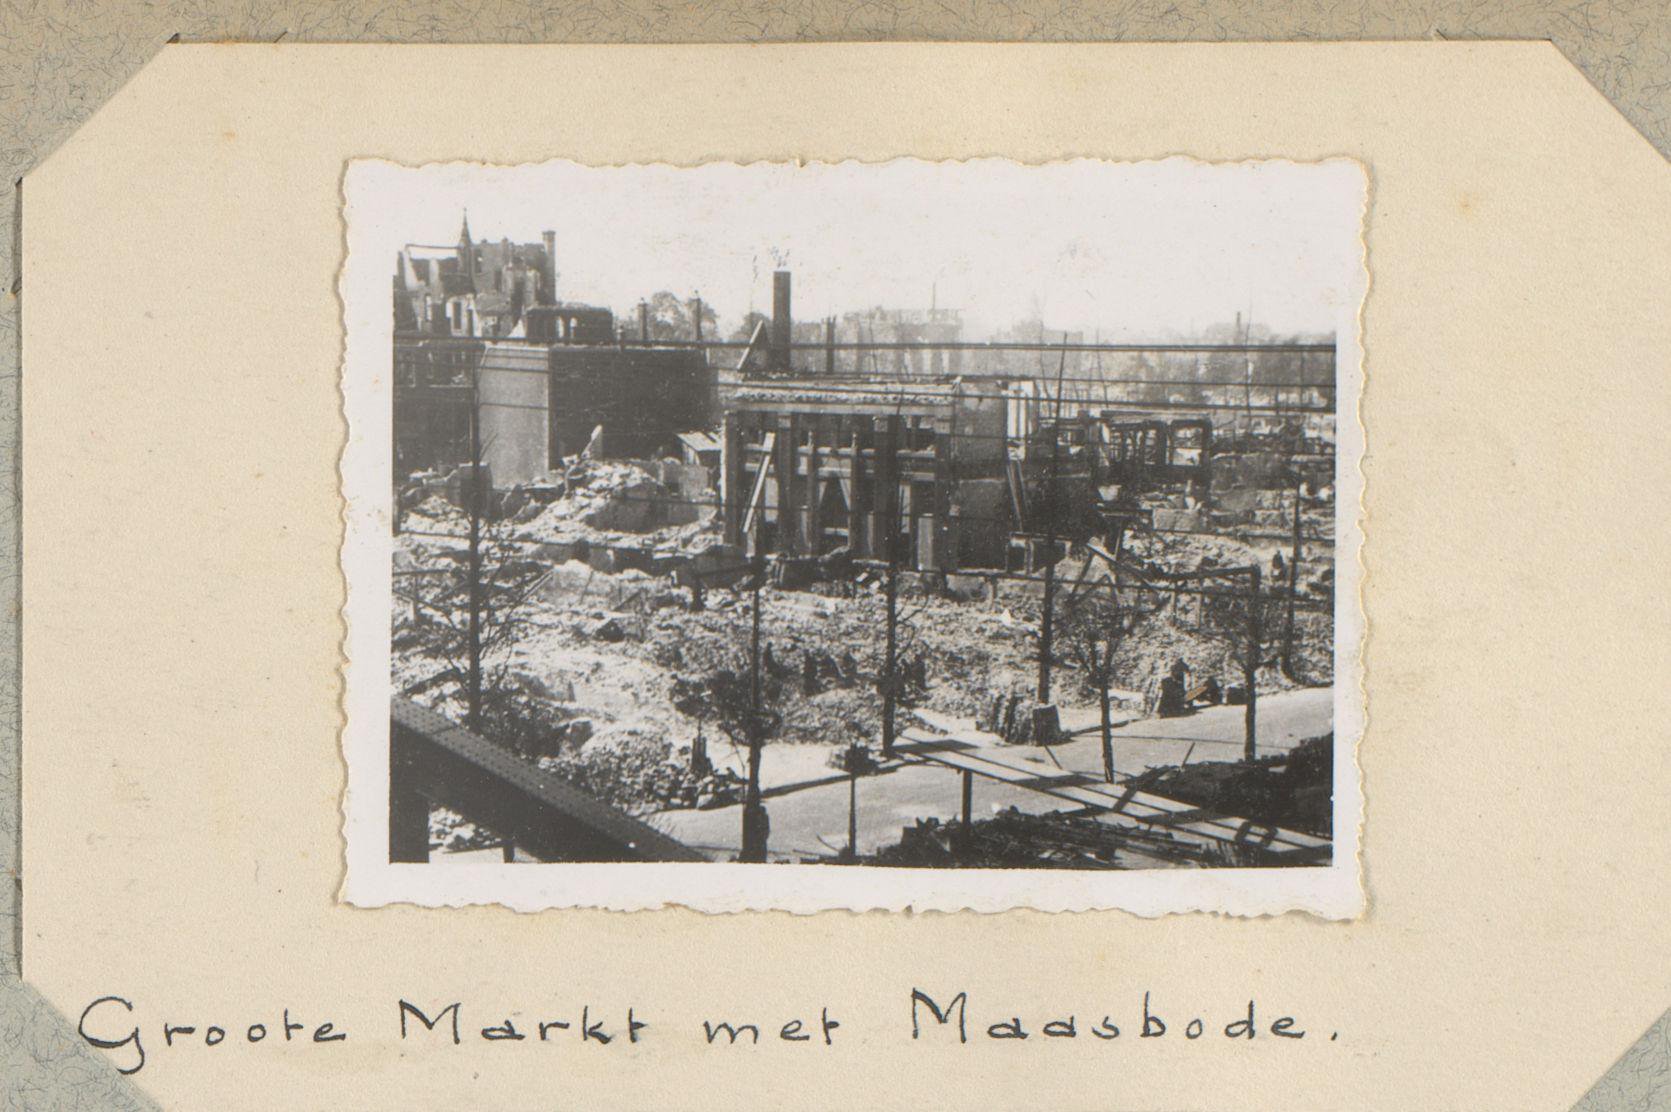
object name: photograph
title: Ruïnes aan de Grote Markt bij de Maasbode te Rotterdam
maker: j. nolte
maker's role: fotograaf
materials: photographic support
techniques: gelatin silver print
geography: rotterdam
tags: devastated, ruined place or city (~ warfare), ruin of a dwelling, house, castle, etc., rotterdam, rotterdam blitz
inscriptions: annotation: ‘Groote Markt met Maasbode.’